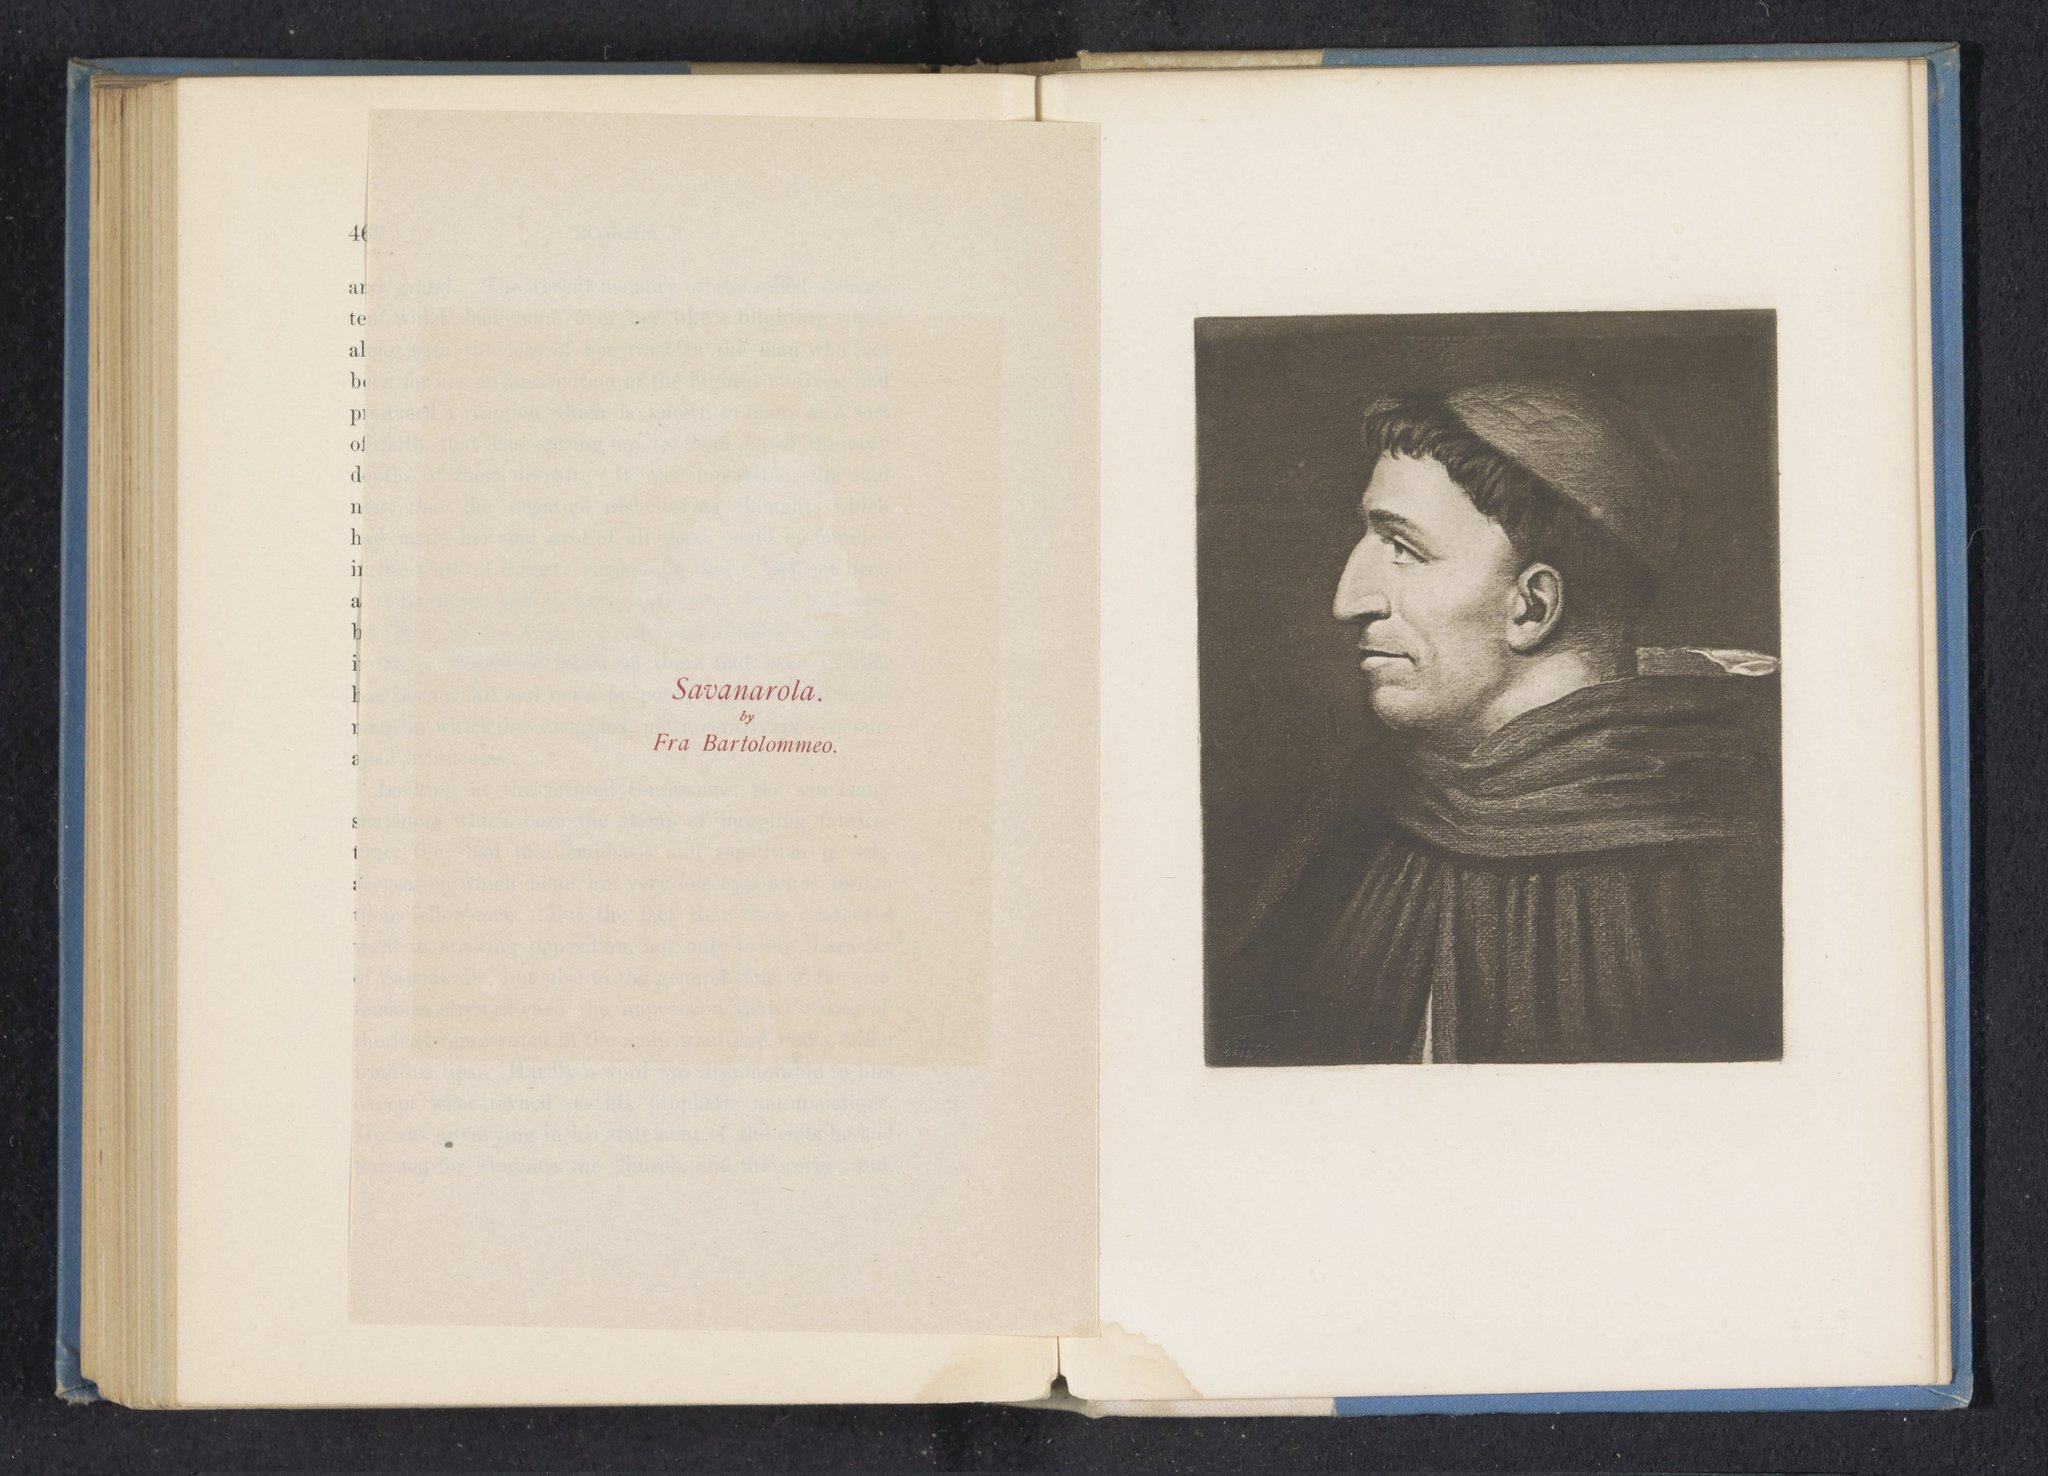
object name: reproduction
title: Fotoreproductie van een tekening, voorstellende een portret van Girolamo Savonarola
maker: Anonymous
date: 1880-1890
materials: paper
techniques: photoaquatint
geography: boston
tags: politician, politician, e.g. party leader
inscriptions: title: ‘Savanarola, by Fra Bartolommeo.’